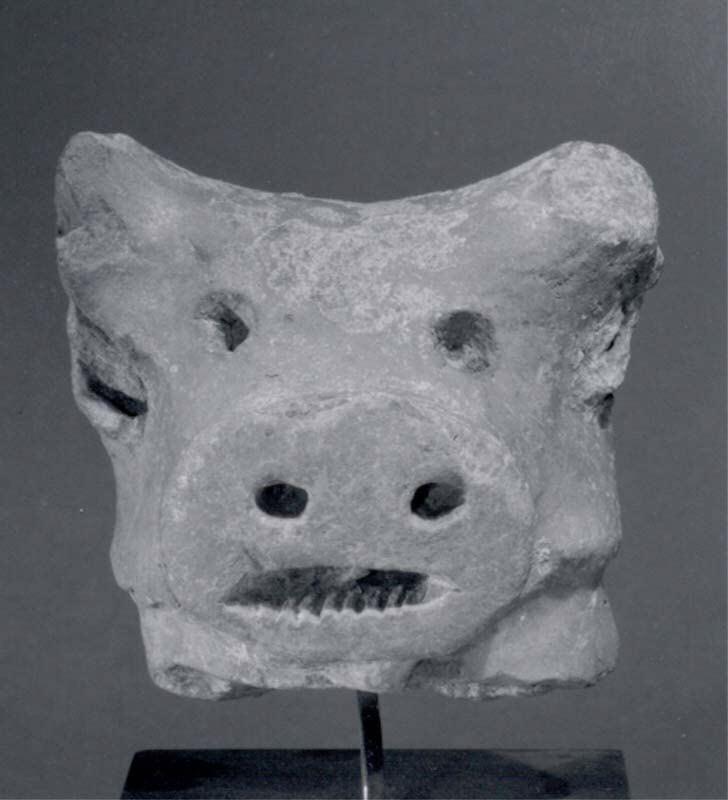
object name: sculpture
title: Head of bull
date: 800-701 BCE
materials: ceramic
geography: levant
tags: bulls